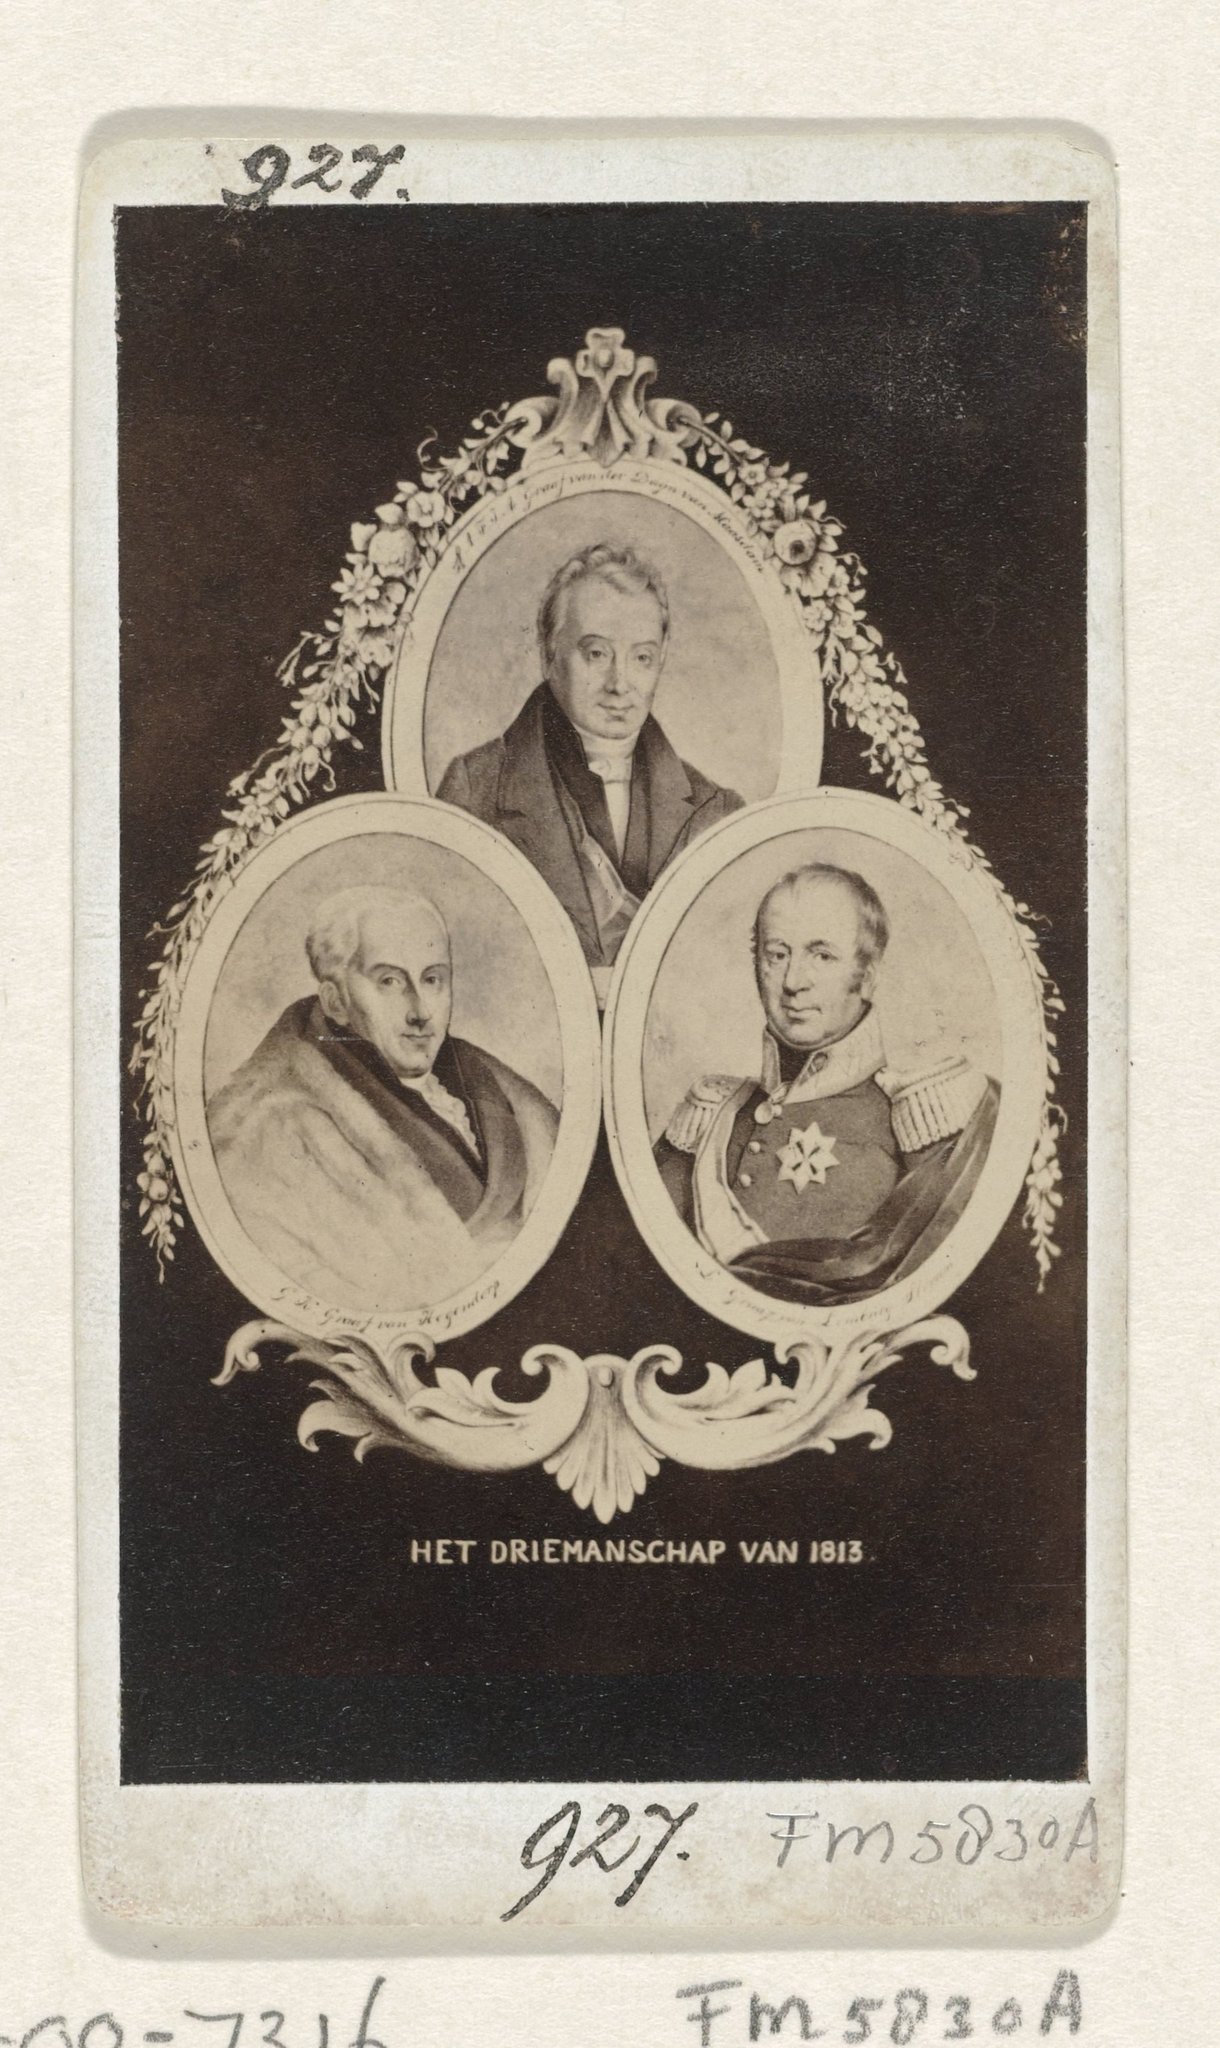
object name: photograph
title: Het driemanschap van 1813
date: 1863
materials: paper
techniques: photography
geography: rotterdam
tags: the hague, gijsbert karel graaf van hogendorp, lille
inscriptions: inscription: ‘Den Ondergetekenden verklaren dat omstaande photographie in hun atelier is vervaardigd. Rotterdam den 10 Octo: 1863 Caro en van Loo / Den ondergetekende verklaart dat omstaande portretten door hem zijn uitgegeven Rotterdam 10 October 1863 .... [onleesbaar]’, inscription: ‘927’, workshop stamp: ‘Caro & Van Loo / Rotterdam / Weenaplein’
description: Het driemanschap van 1813. Drie portretten in medaillons van G.K. van Hogendorp, L. van Limburg Stirum en A.F. van Duyn van Maasdam. Waarschijnlijk vervaardigd bij het vijftigjarig jubileum van de aanvaarding van het Hoog Bewind door het Driemanschap in naam van de prins van Oranje, 21 november 1813.